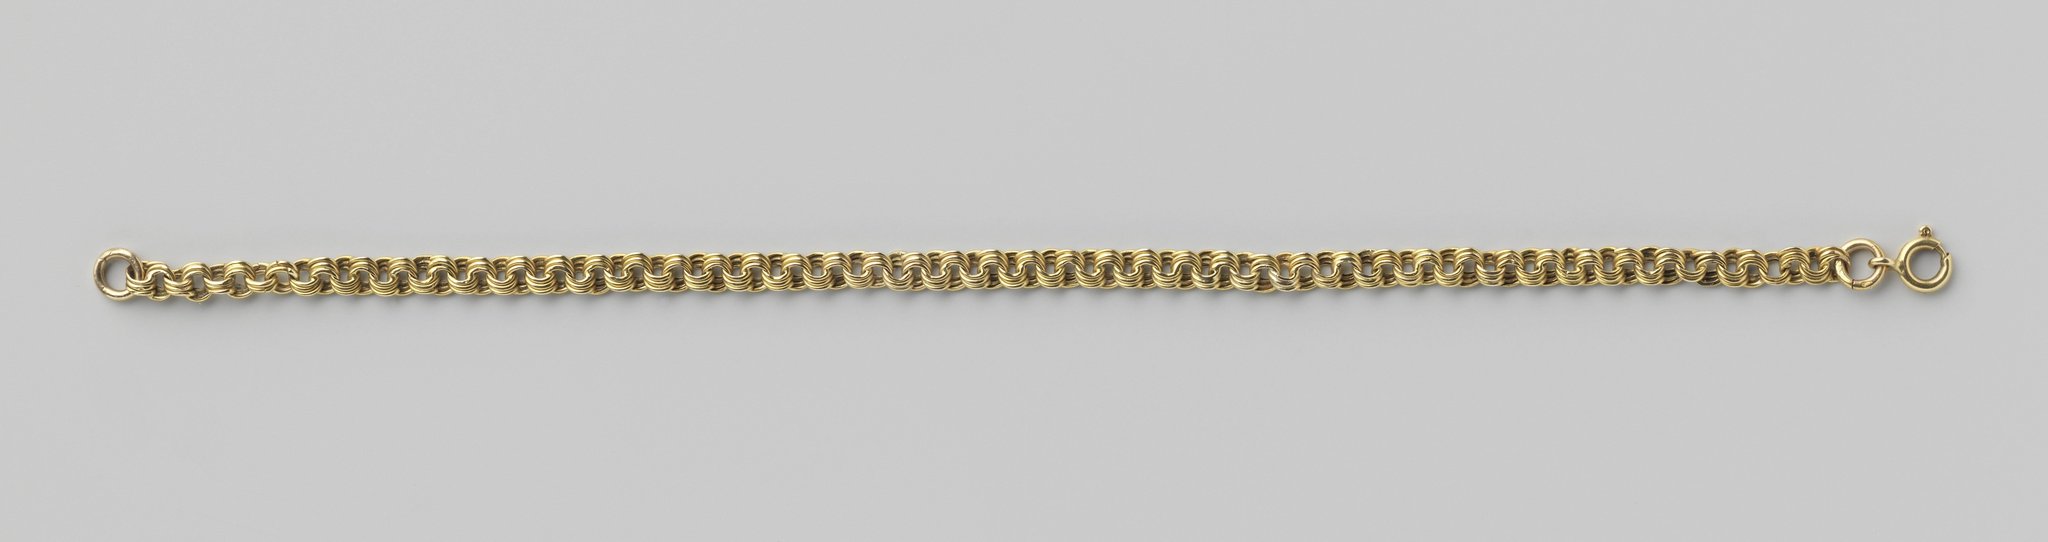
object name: bracelet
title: Armband van goud van Wilhelminaschakels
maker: Anonymous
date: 1900-1910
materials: gold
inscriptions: alloy mark, maker's mark, : ‘2’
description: Armband van goud van Wilhelminaschakels voorzien van een veerring.